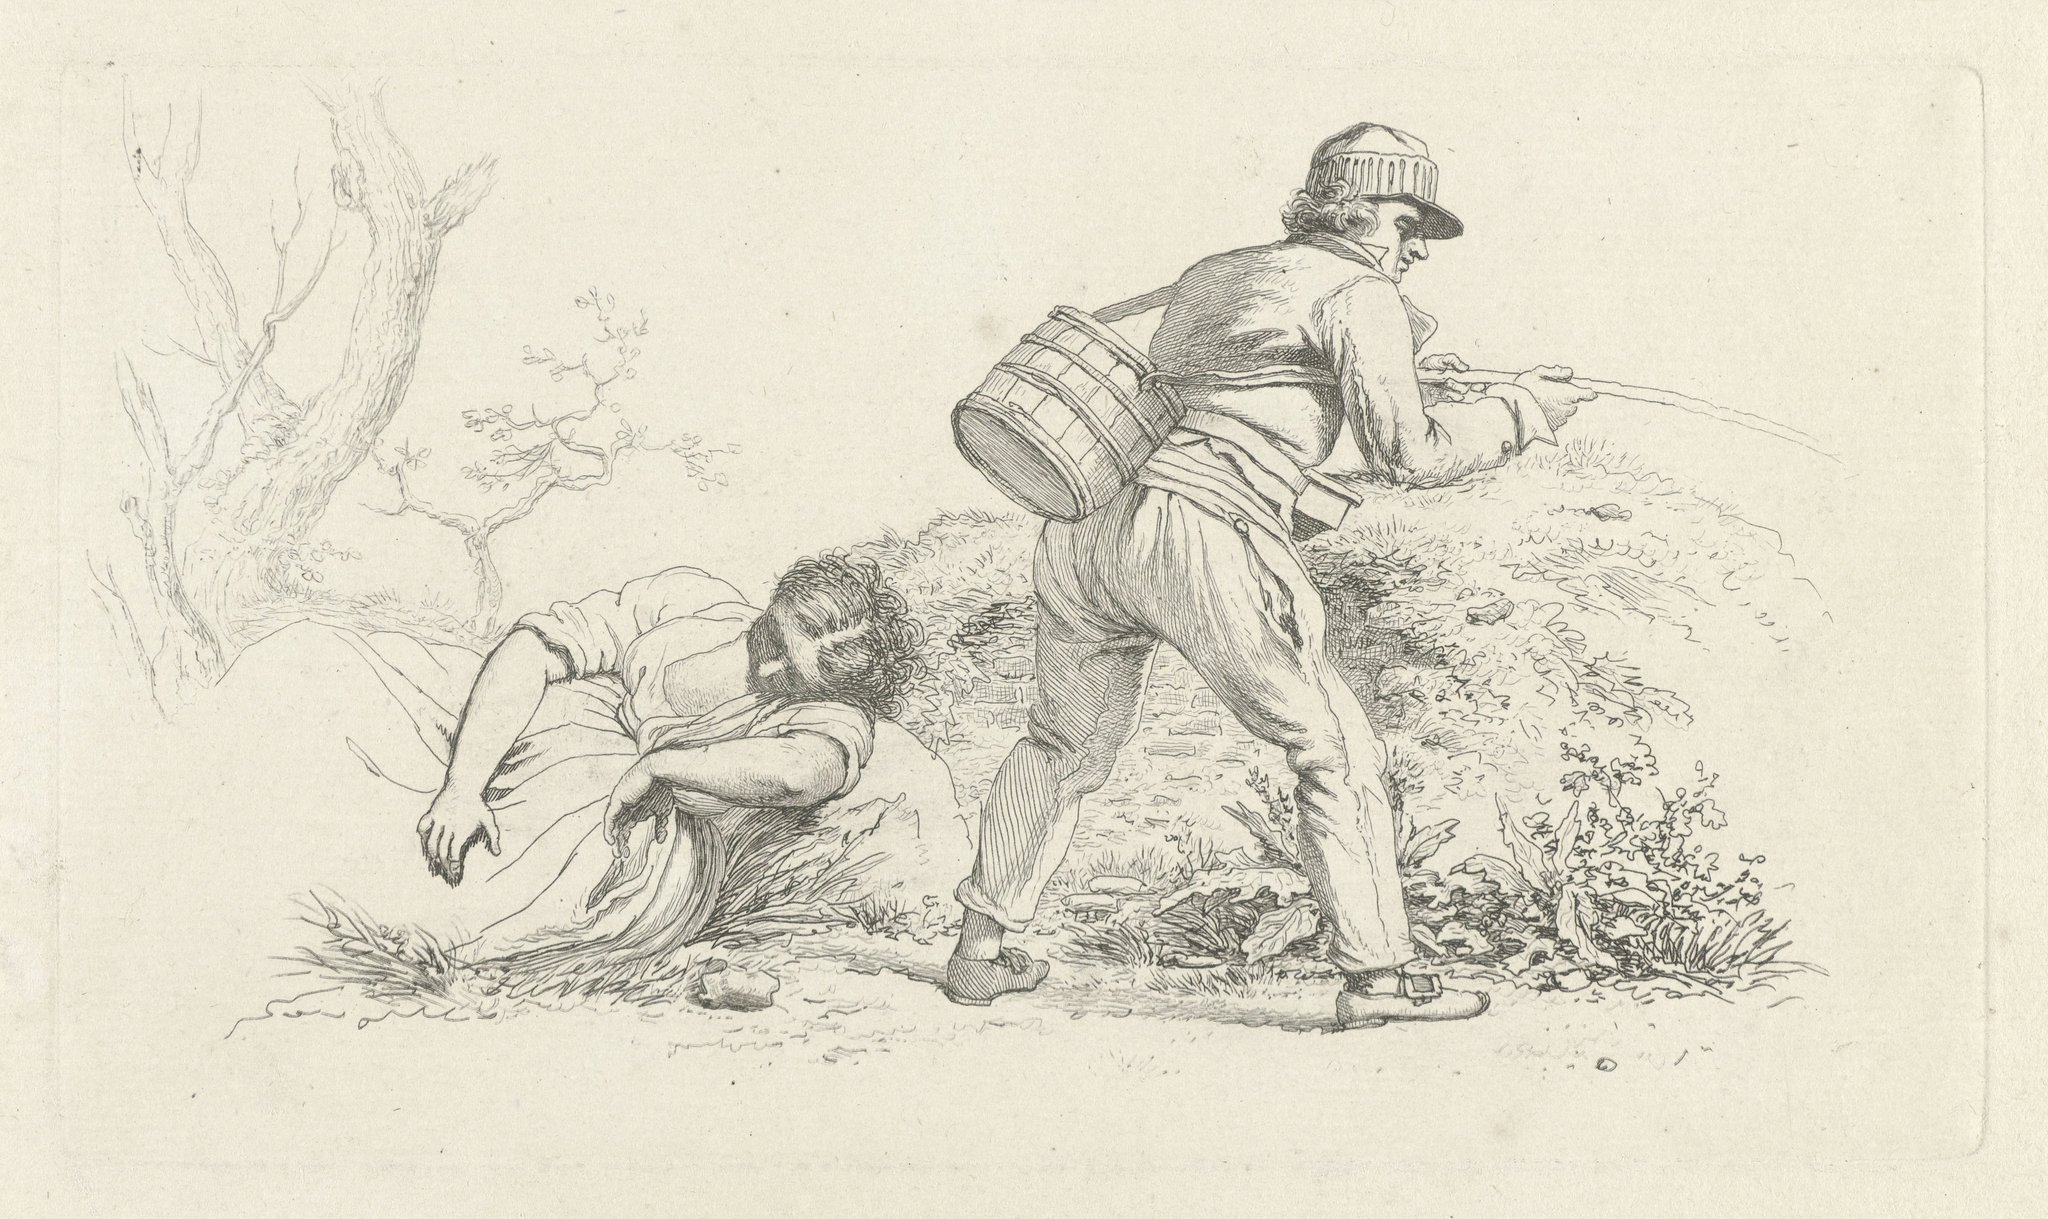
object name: print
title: Studie-prentwerk / Etudes gravées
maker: jacob ernst marcus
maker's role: draughtsman, print maker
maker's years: 1774-1826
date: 1805-1808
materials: paper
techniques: etching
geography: amsterdam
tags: sleeping on the ground - bb - out of doors, angling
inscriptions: collector's mark: Lugt 2228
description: Serie voor het eerst uitgegeven door Jacob Ernst Marcus onder de titel Studiebeelden en Fragmenten. Amsterdam: ca.1816. Later heruitgegeven als: Studie-prentwerk/ Etudes gravées.